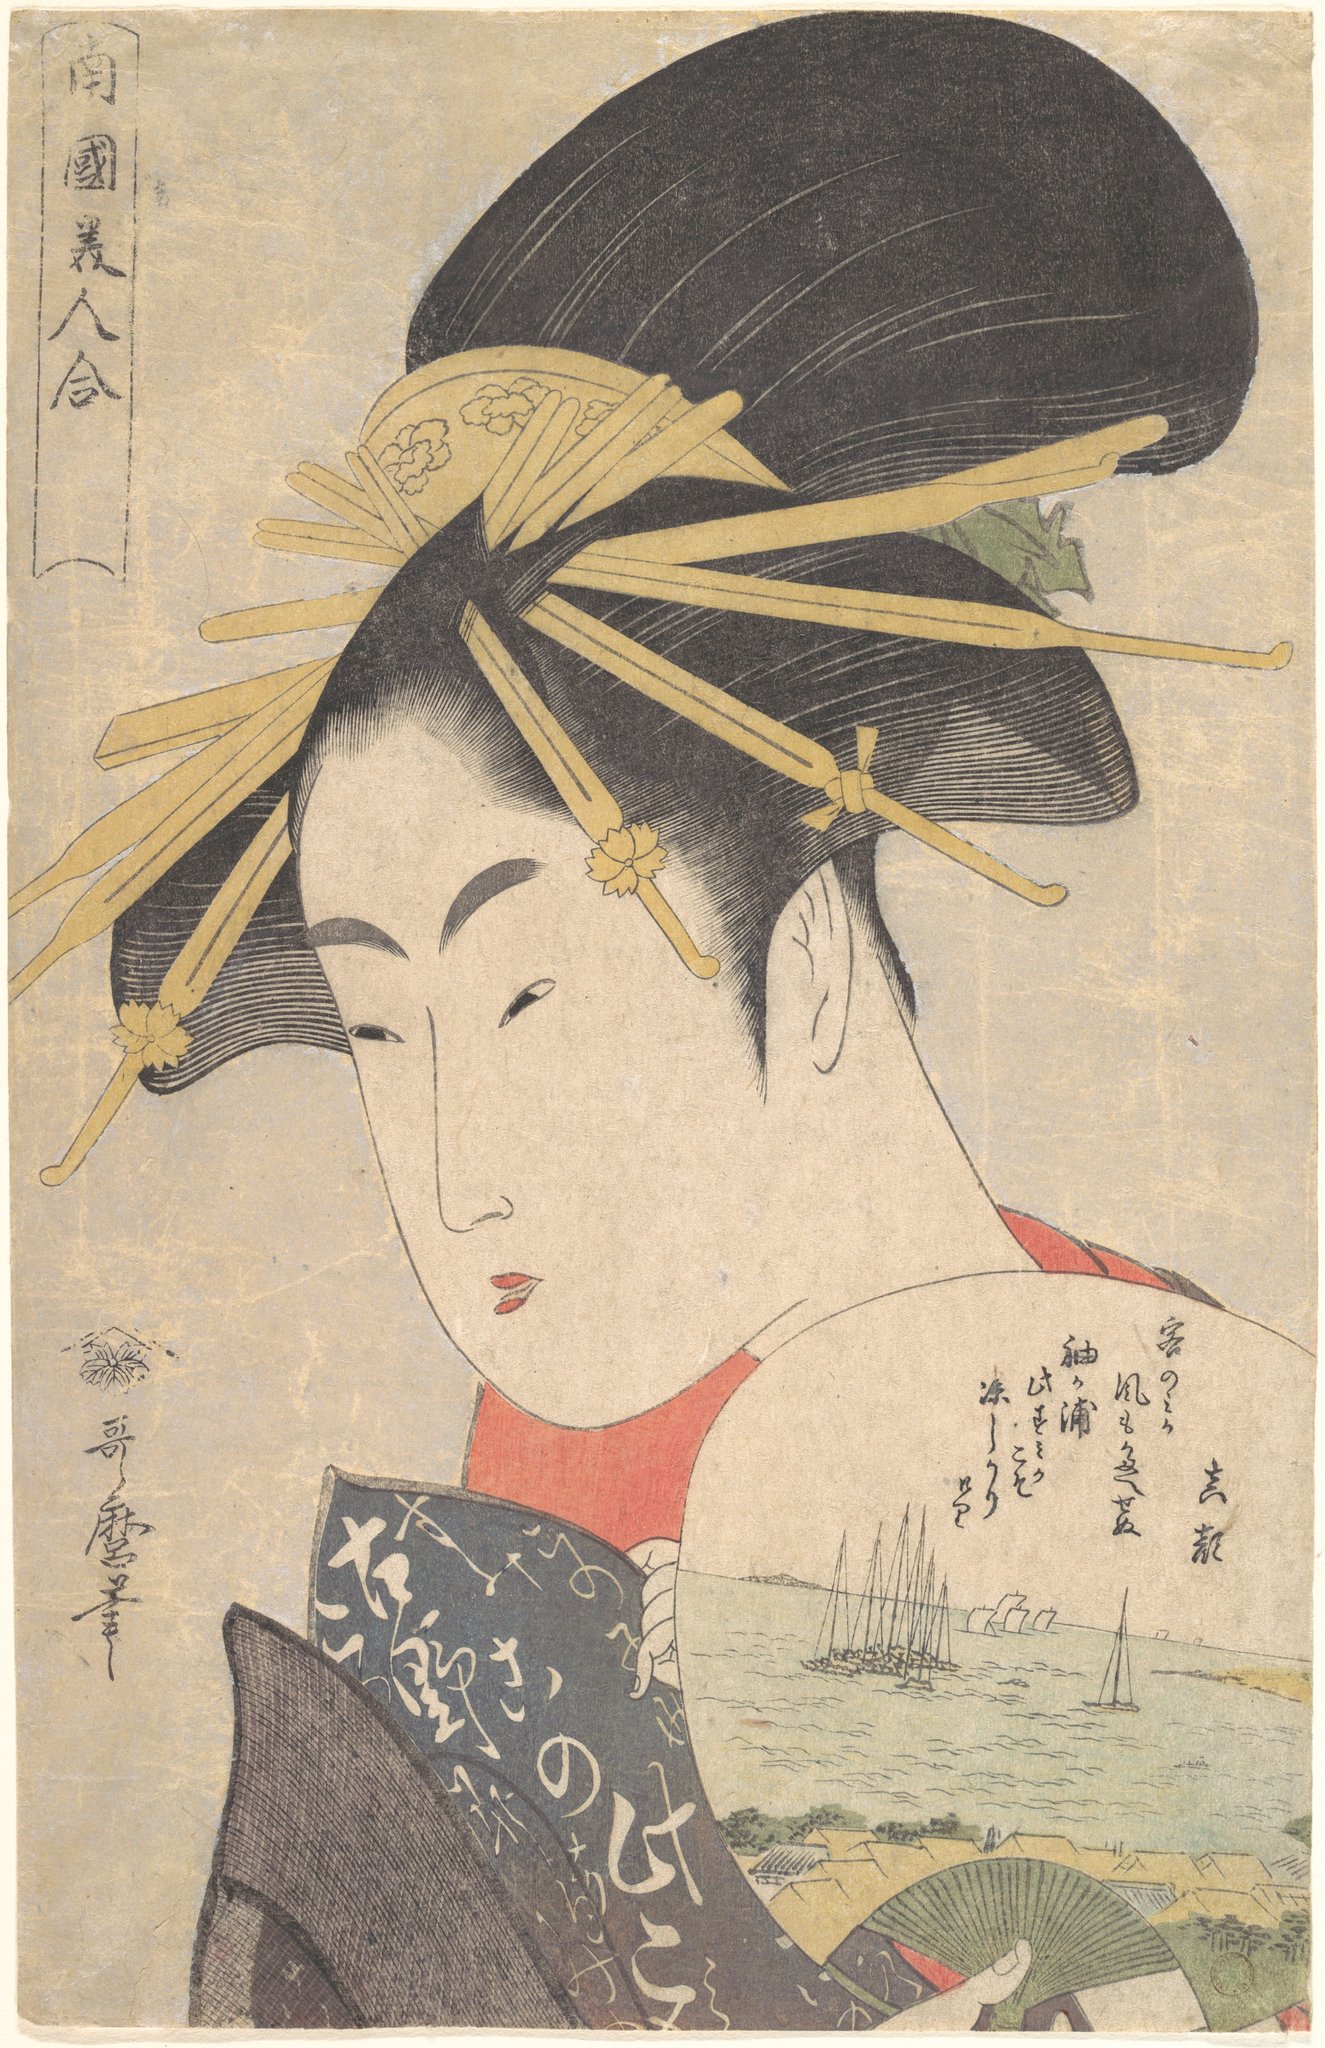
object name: print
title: The Courtesan Konosumi, from the series “Beauties of the Southern Quarter”(Nangoku bijin awase)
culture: japanese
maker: kitagawa utamaro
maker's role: artist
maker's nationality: japanese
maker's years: 1754-1806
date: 1793-1794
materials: ink, paper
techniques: woodblock print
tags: fans,women